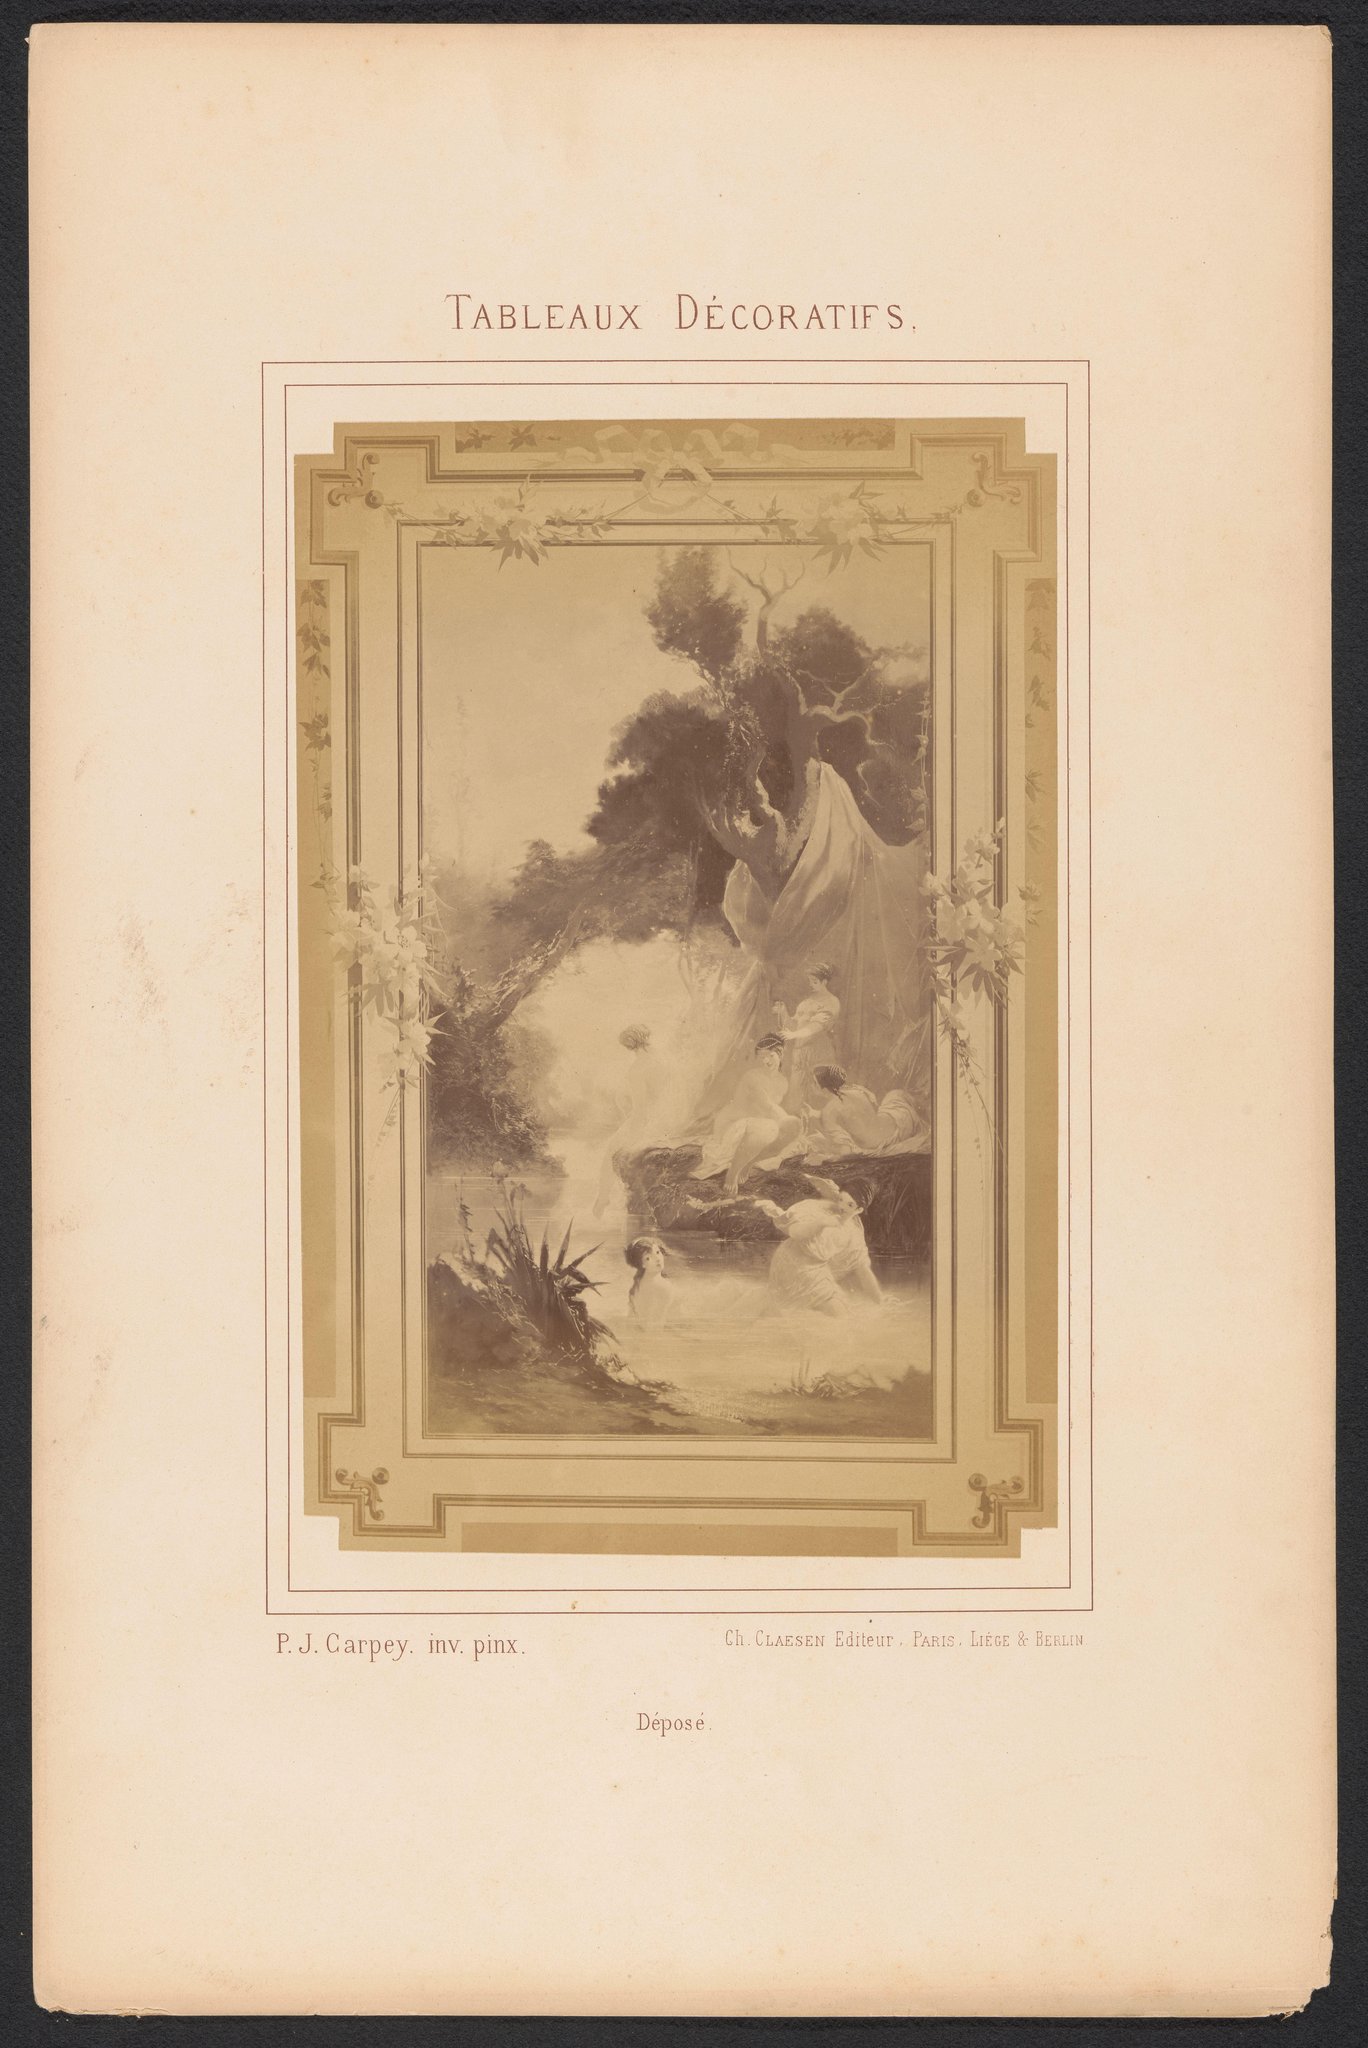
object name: reproduction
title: Fotoreproductie van een schilderij van zes badende en zonnende vrouwen door P. J. Carpey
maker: paul-joseph carpay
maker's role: painter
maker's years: 1822-1892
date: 1874-1881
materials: photographic support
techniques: albumen print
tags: swimming (movement in water) - aa - female human figure, cupids: 'amores', 'amoretti', 'putti'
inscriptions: inscription: ‘Ch. Claesen Editeur , Paris , Liége & Berlin’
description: Deze foto maakt deel uit van een omslag met 24 foto's op 22 bladen.